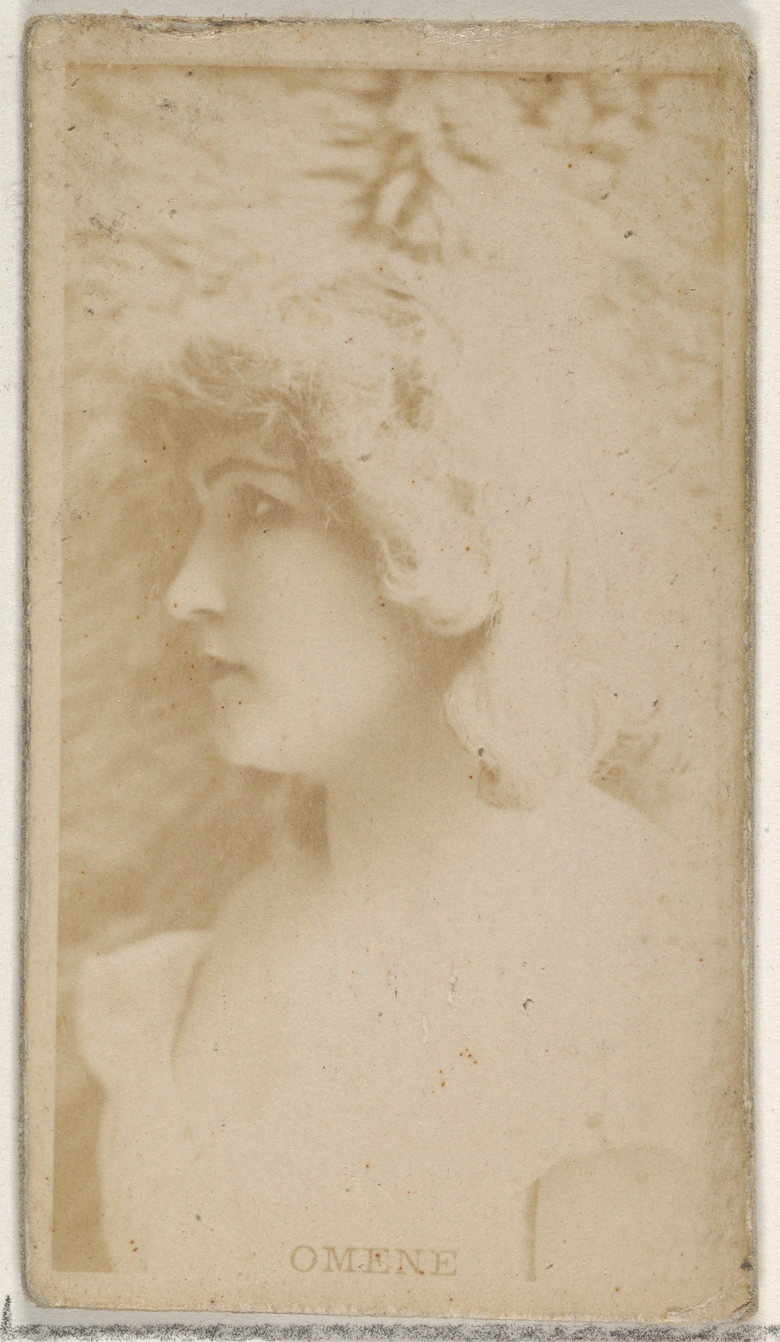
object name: photograph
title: Omene, from the Actors and Actresses series (N45, Type 8) for Virginia Brights Cigarettes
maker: allen & ginter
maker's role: publisher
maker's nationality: american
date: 1888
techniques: albumen silver print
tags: portraits,women,actresses